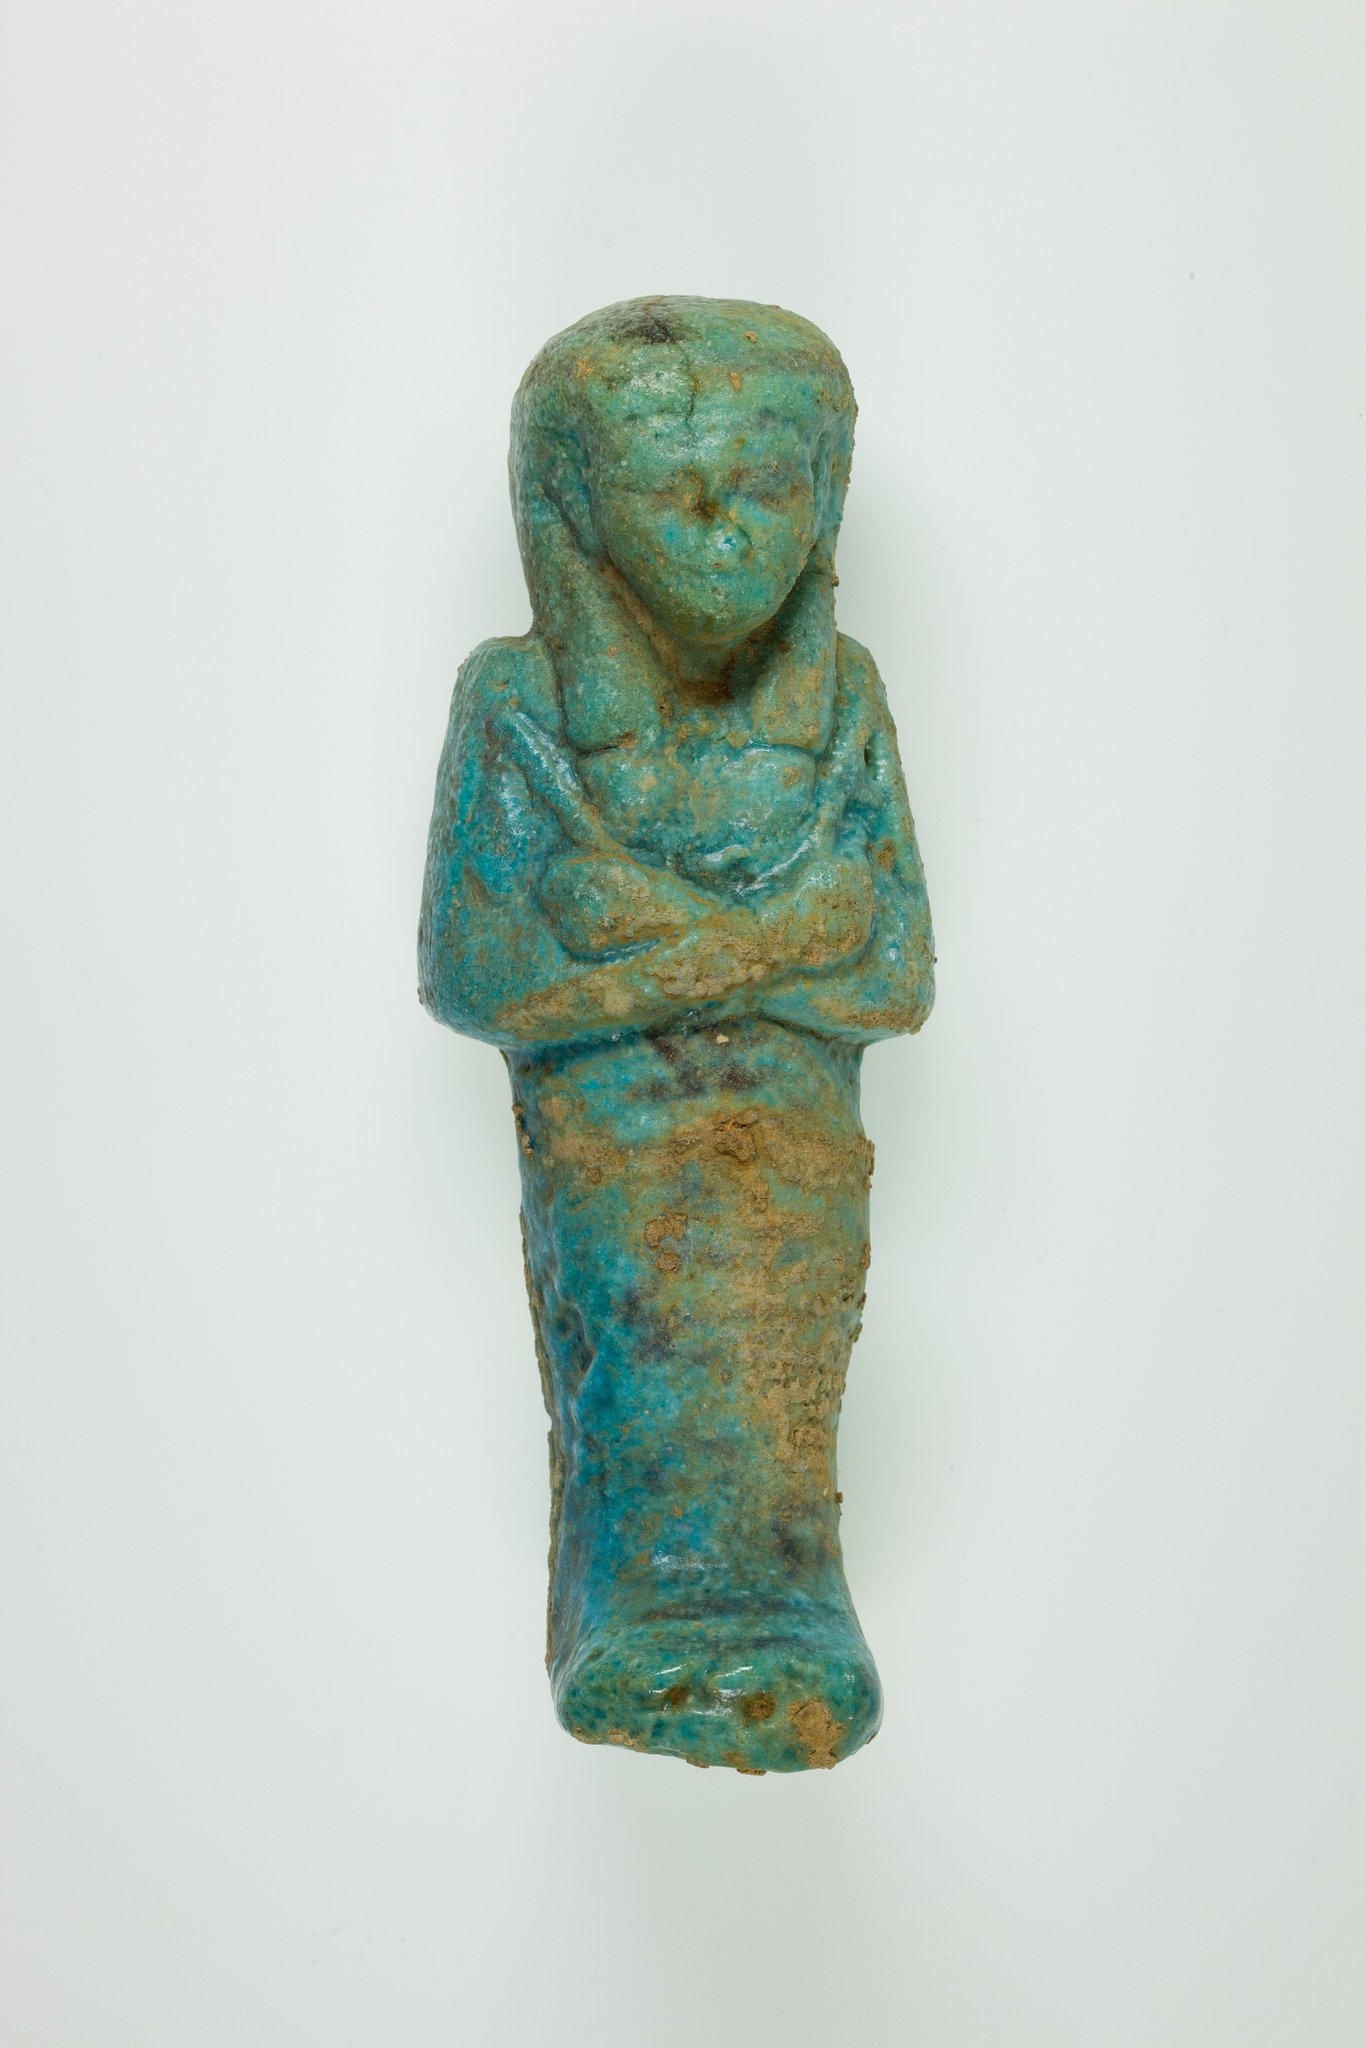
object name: worker shabti, henettawy c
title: Worker Shabti of Henettawy (C), Daughter of Isetemkheb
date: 990-970 BCE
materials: faience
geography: egypt